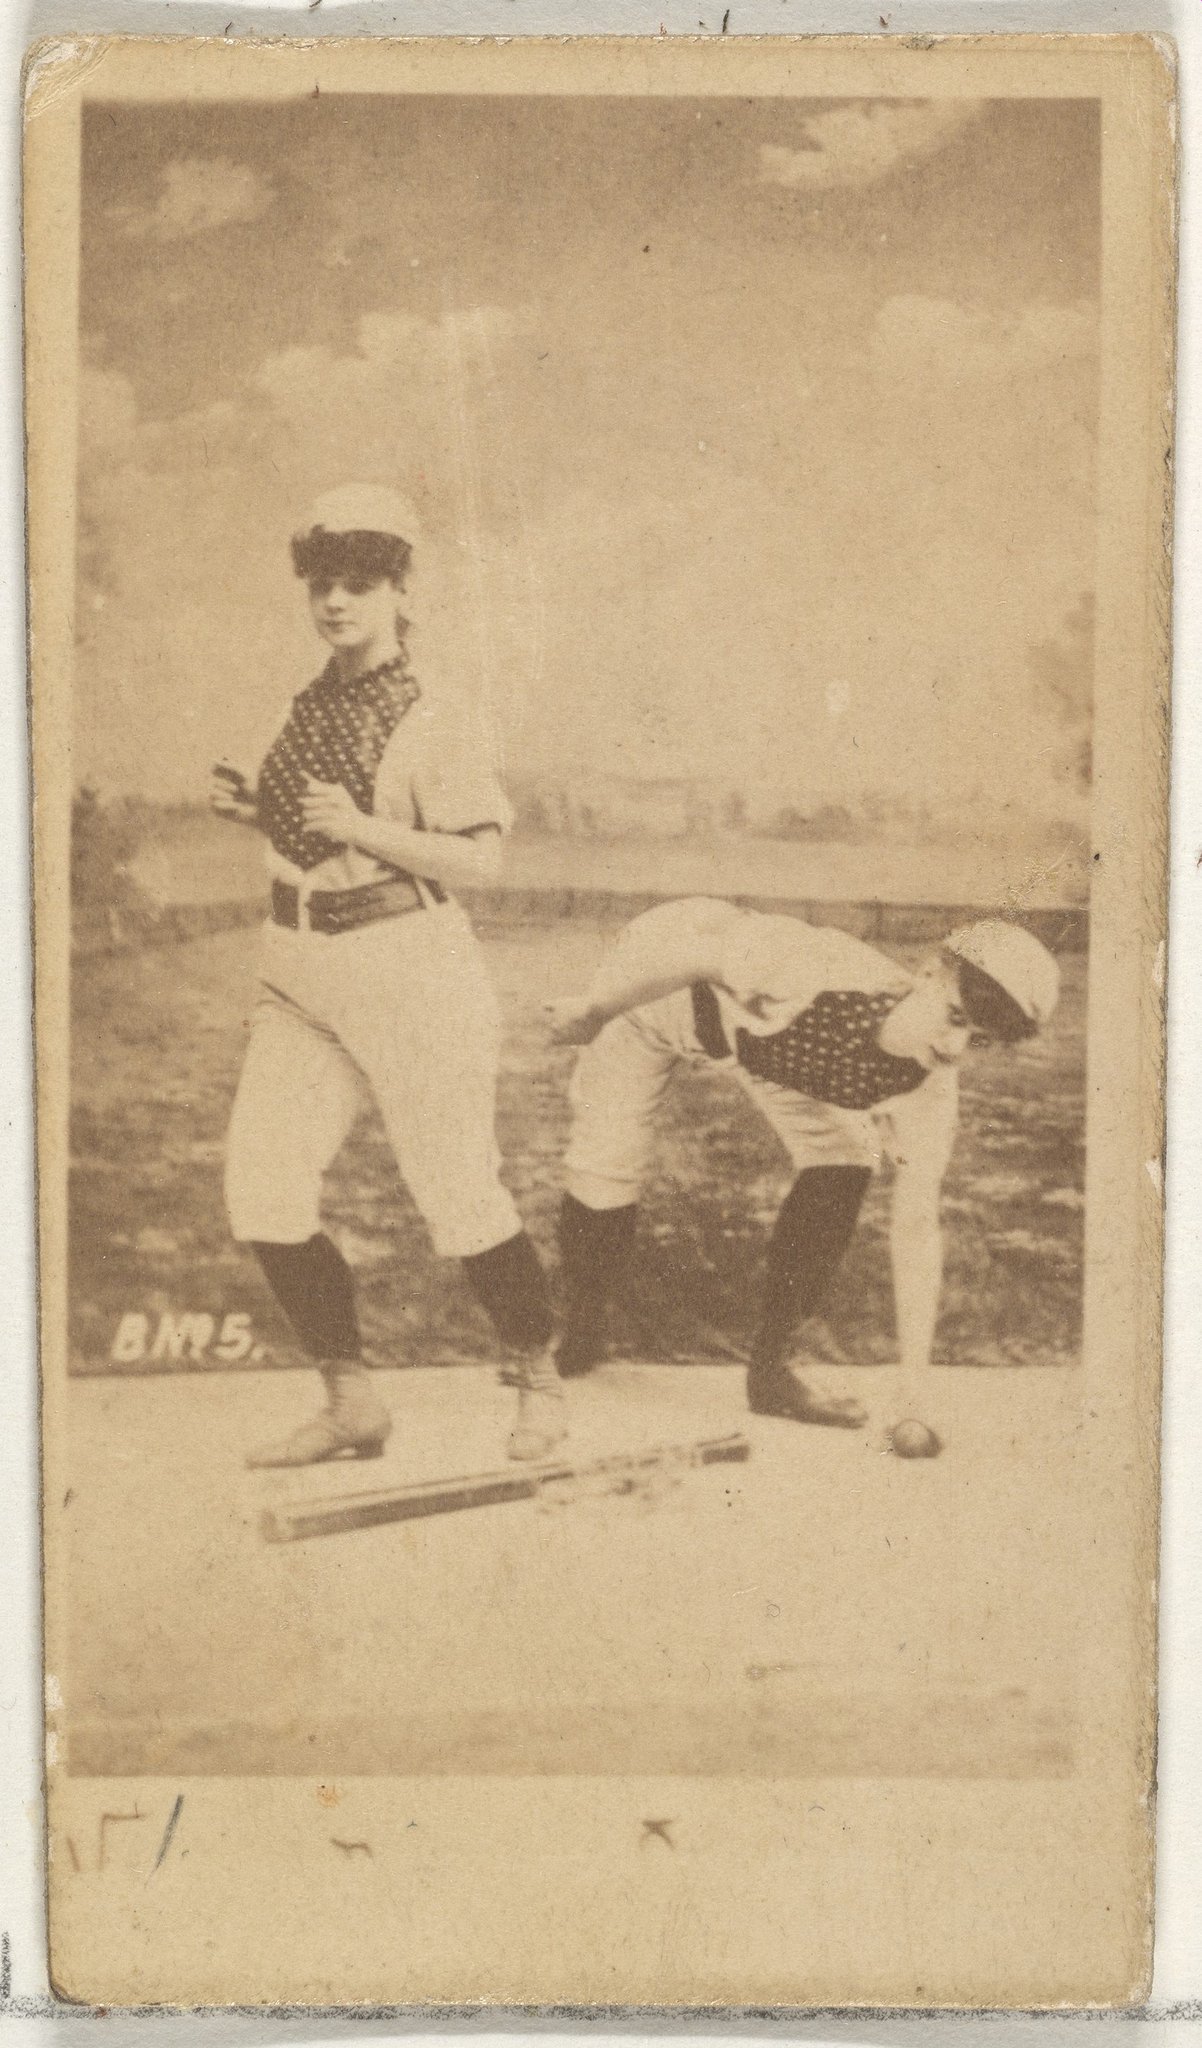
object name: baseball card, photograph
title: Card 5, from the Girl Baseball Players series (N48, Type 1) for Virginia Brights Cigarettes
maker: allen & ginter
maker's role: publisher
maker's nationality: american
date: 1886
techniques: albumen silver print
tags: portraits,women,baseball,athletes